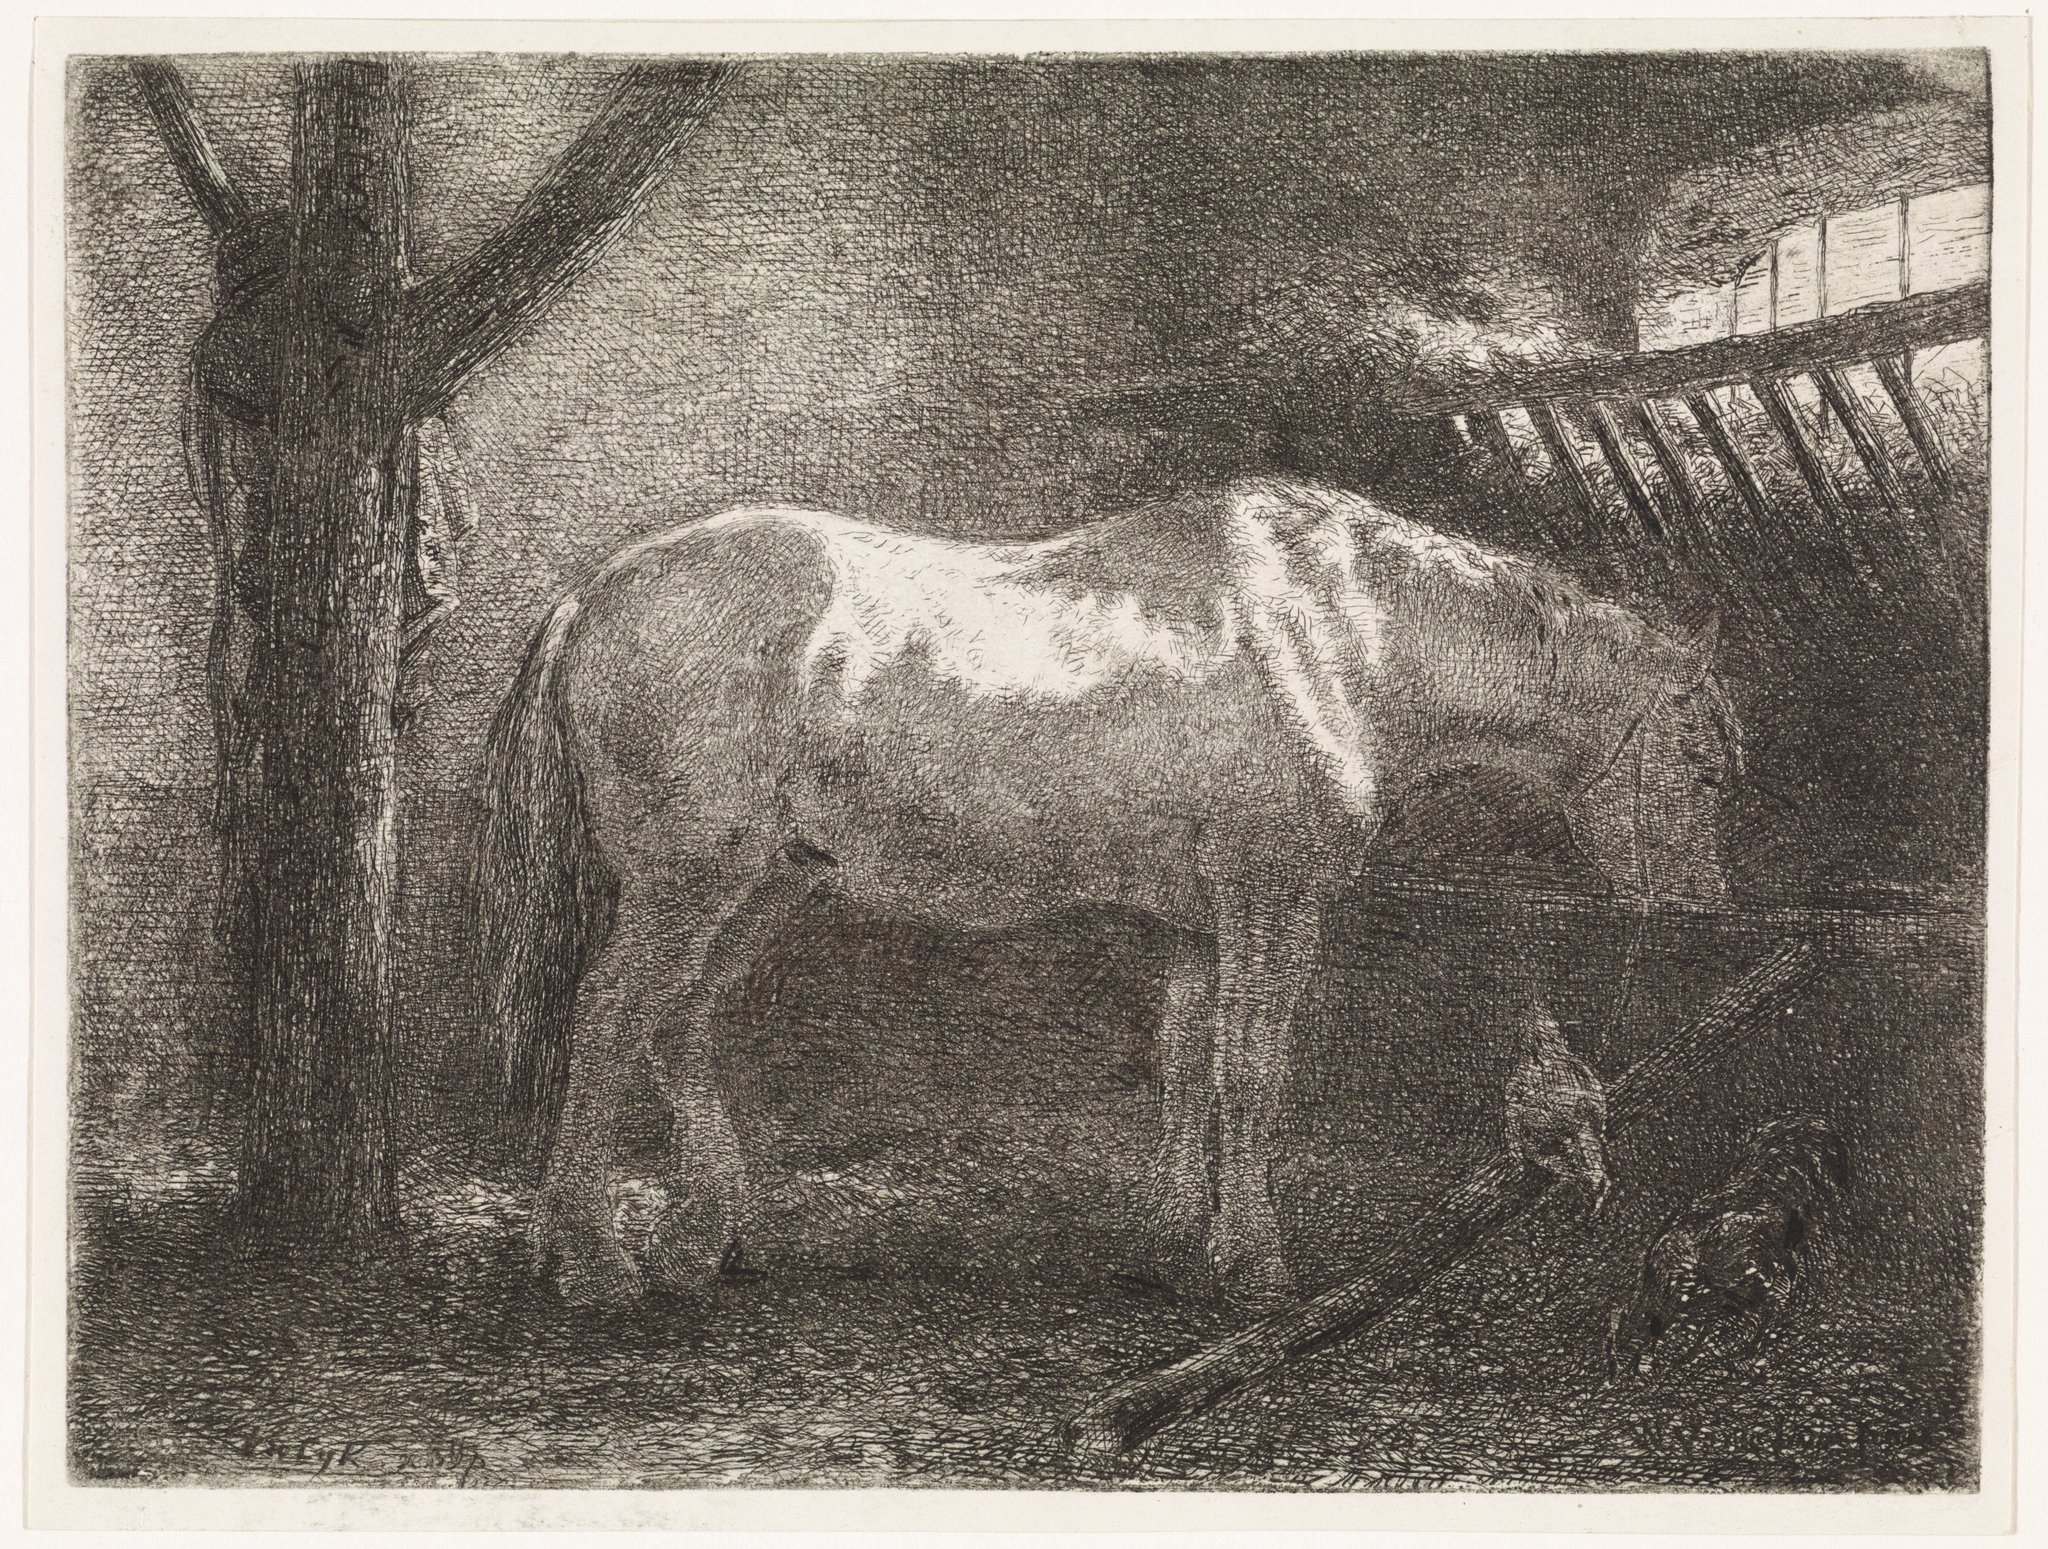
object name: print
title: Paard in stal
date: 1860-1885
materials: paper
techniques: etching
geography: the hague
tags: horses and kindred animals, fowl (cock, hen, chicken, etc.), stall, stable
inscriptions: collector's mark: Lugt 2228